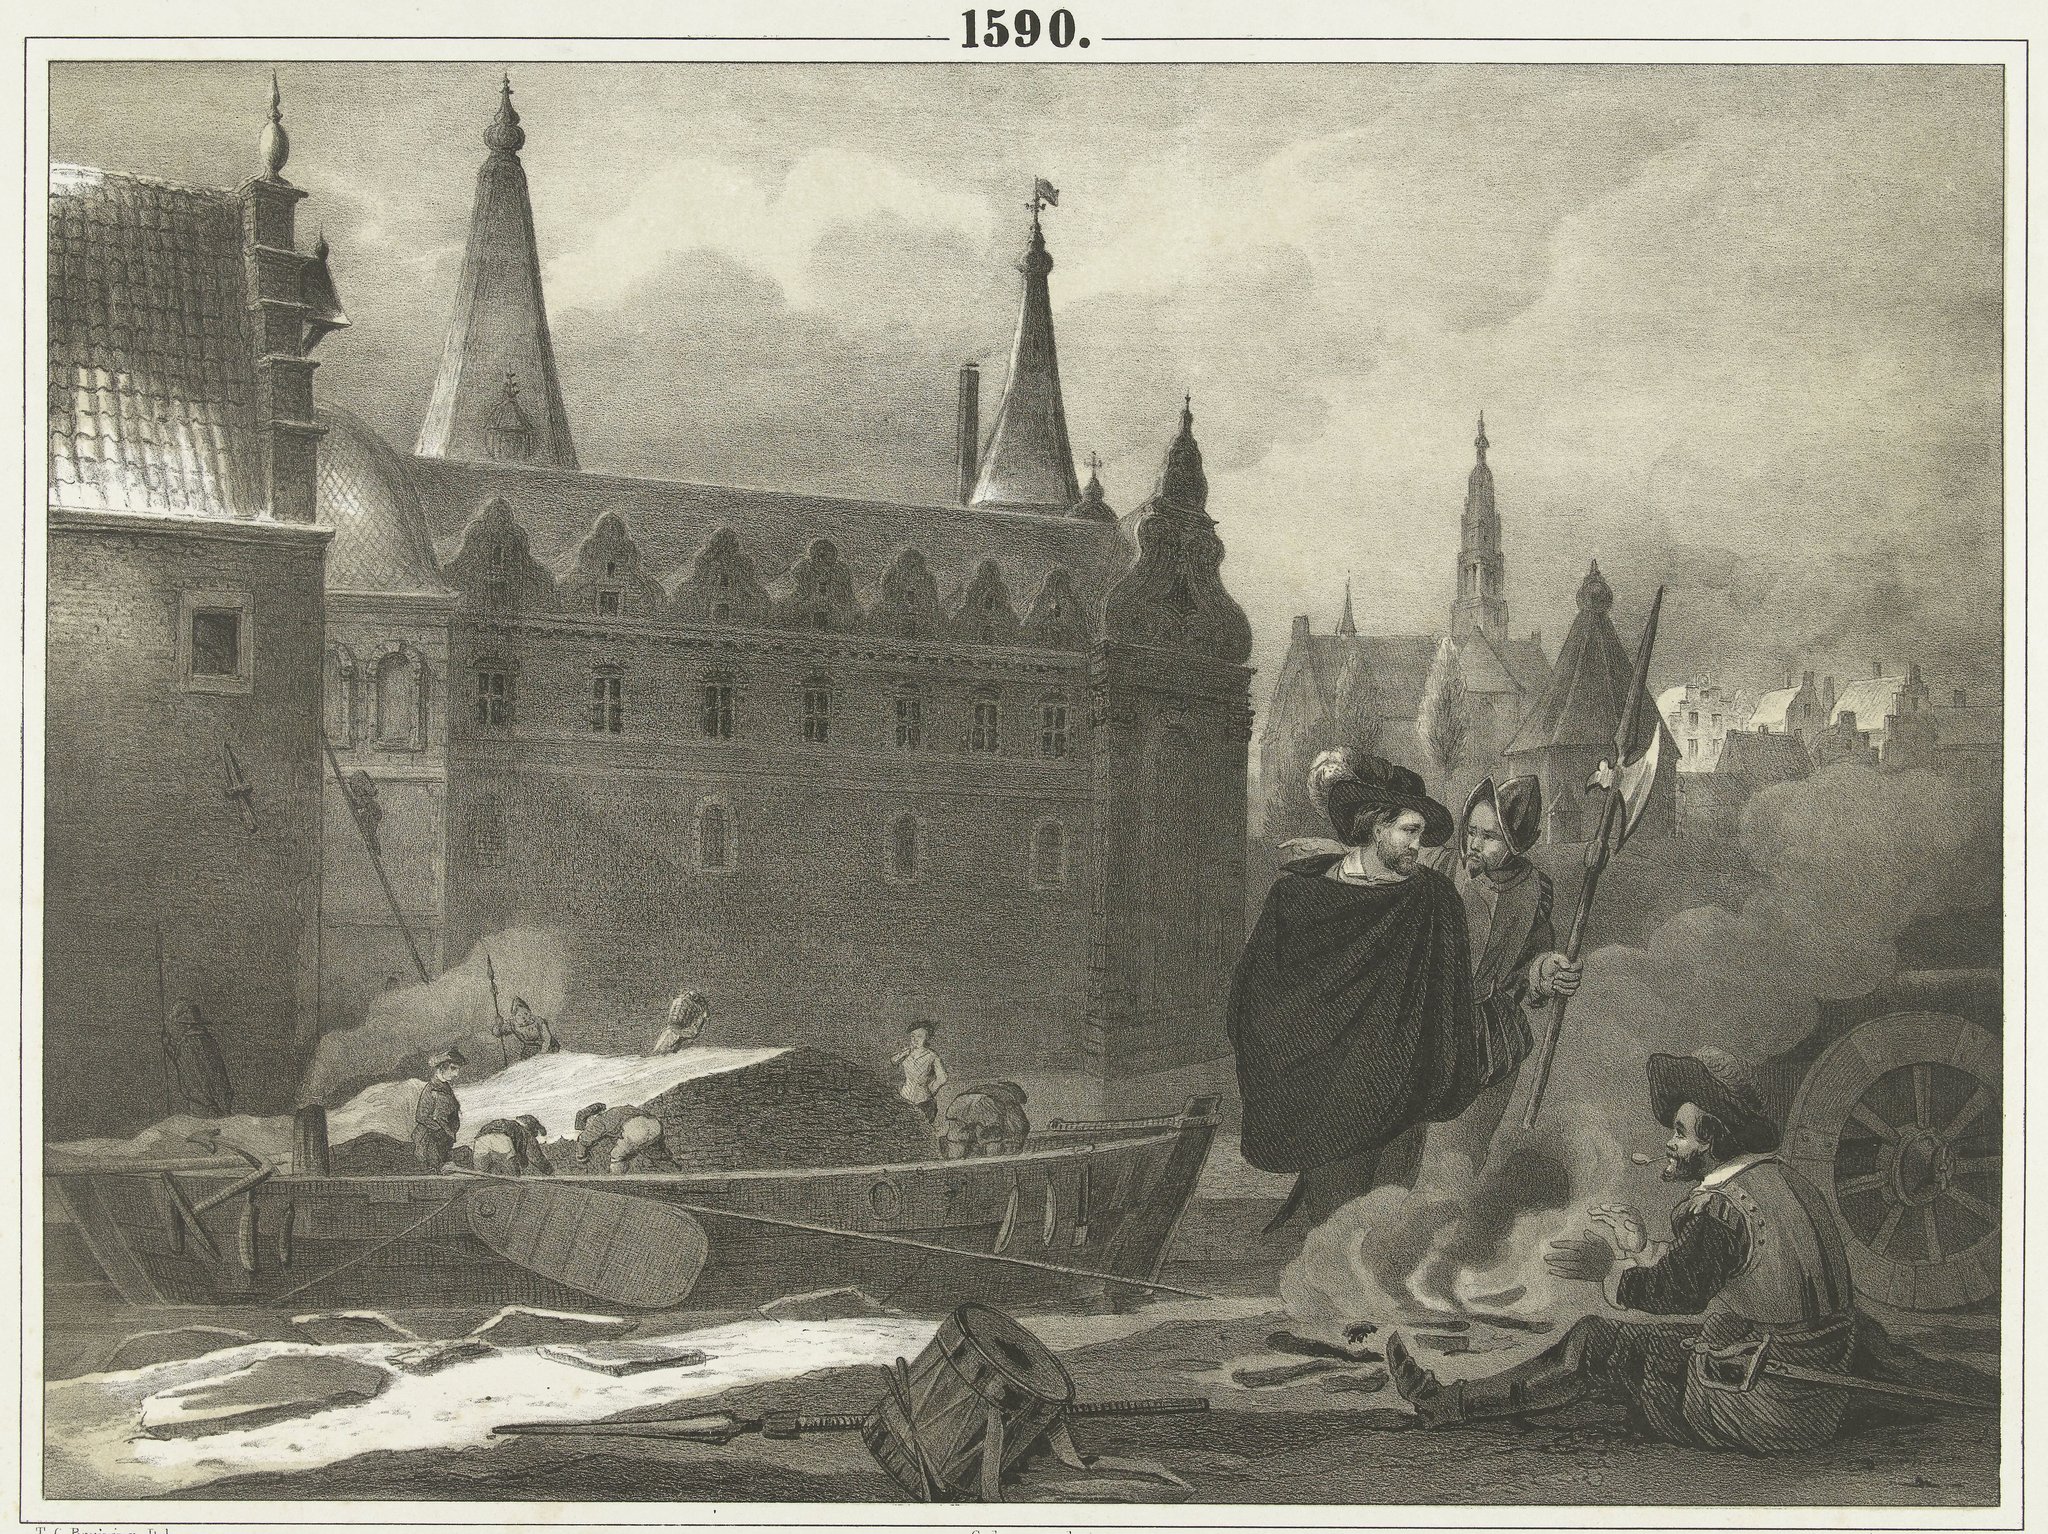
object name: print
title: 1590 / Inneming van Breda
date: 1853-1855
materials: paper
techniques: tone lithography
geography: netherlands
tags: traffic and transport (+ unloading)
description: Gebruikt als illustratie in: J.H. Eichman & H. Altmann, Vaderlandsche historieplaten voor scholen en huisgezinnen, Leiden, 1855. Dit nummer is een door het RPK toegevoegd nummer en staat niet in Frederik Muller, het werk waar de prent voor is gemaakt of uit afkomstig is, staat wel vermeld in Frederik Muller.